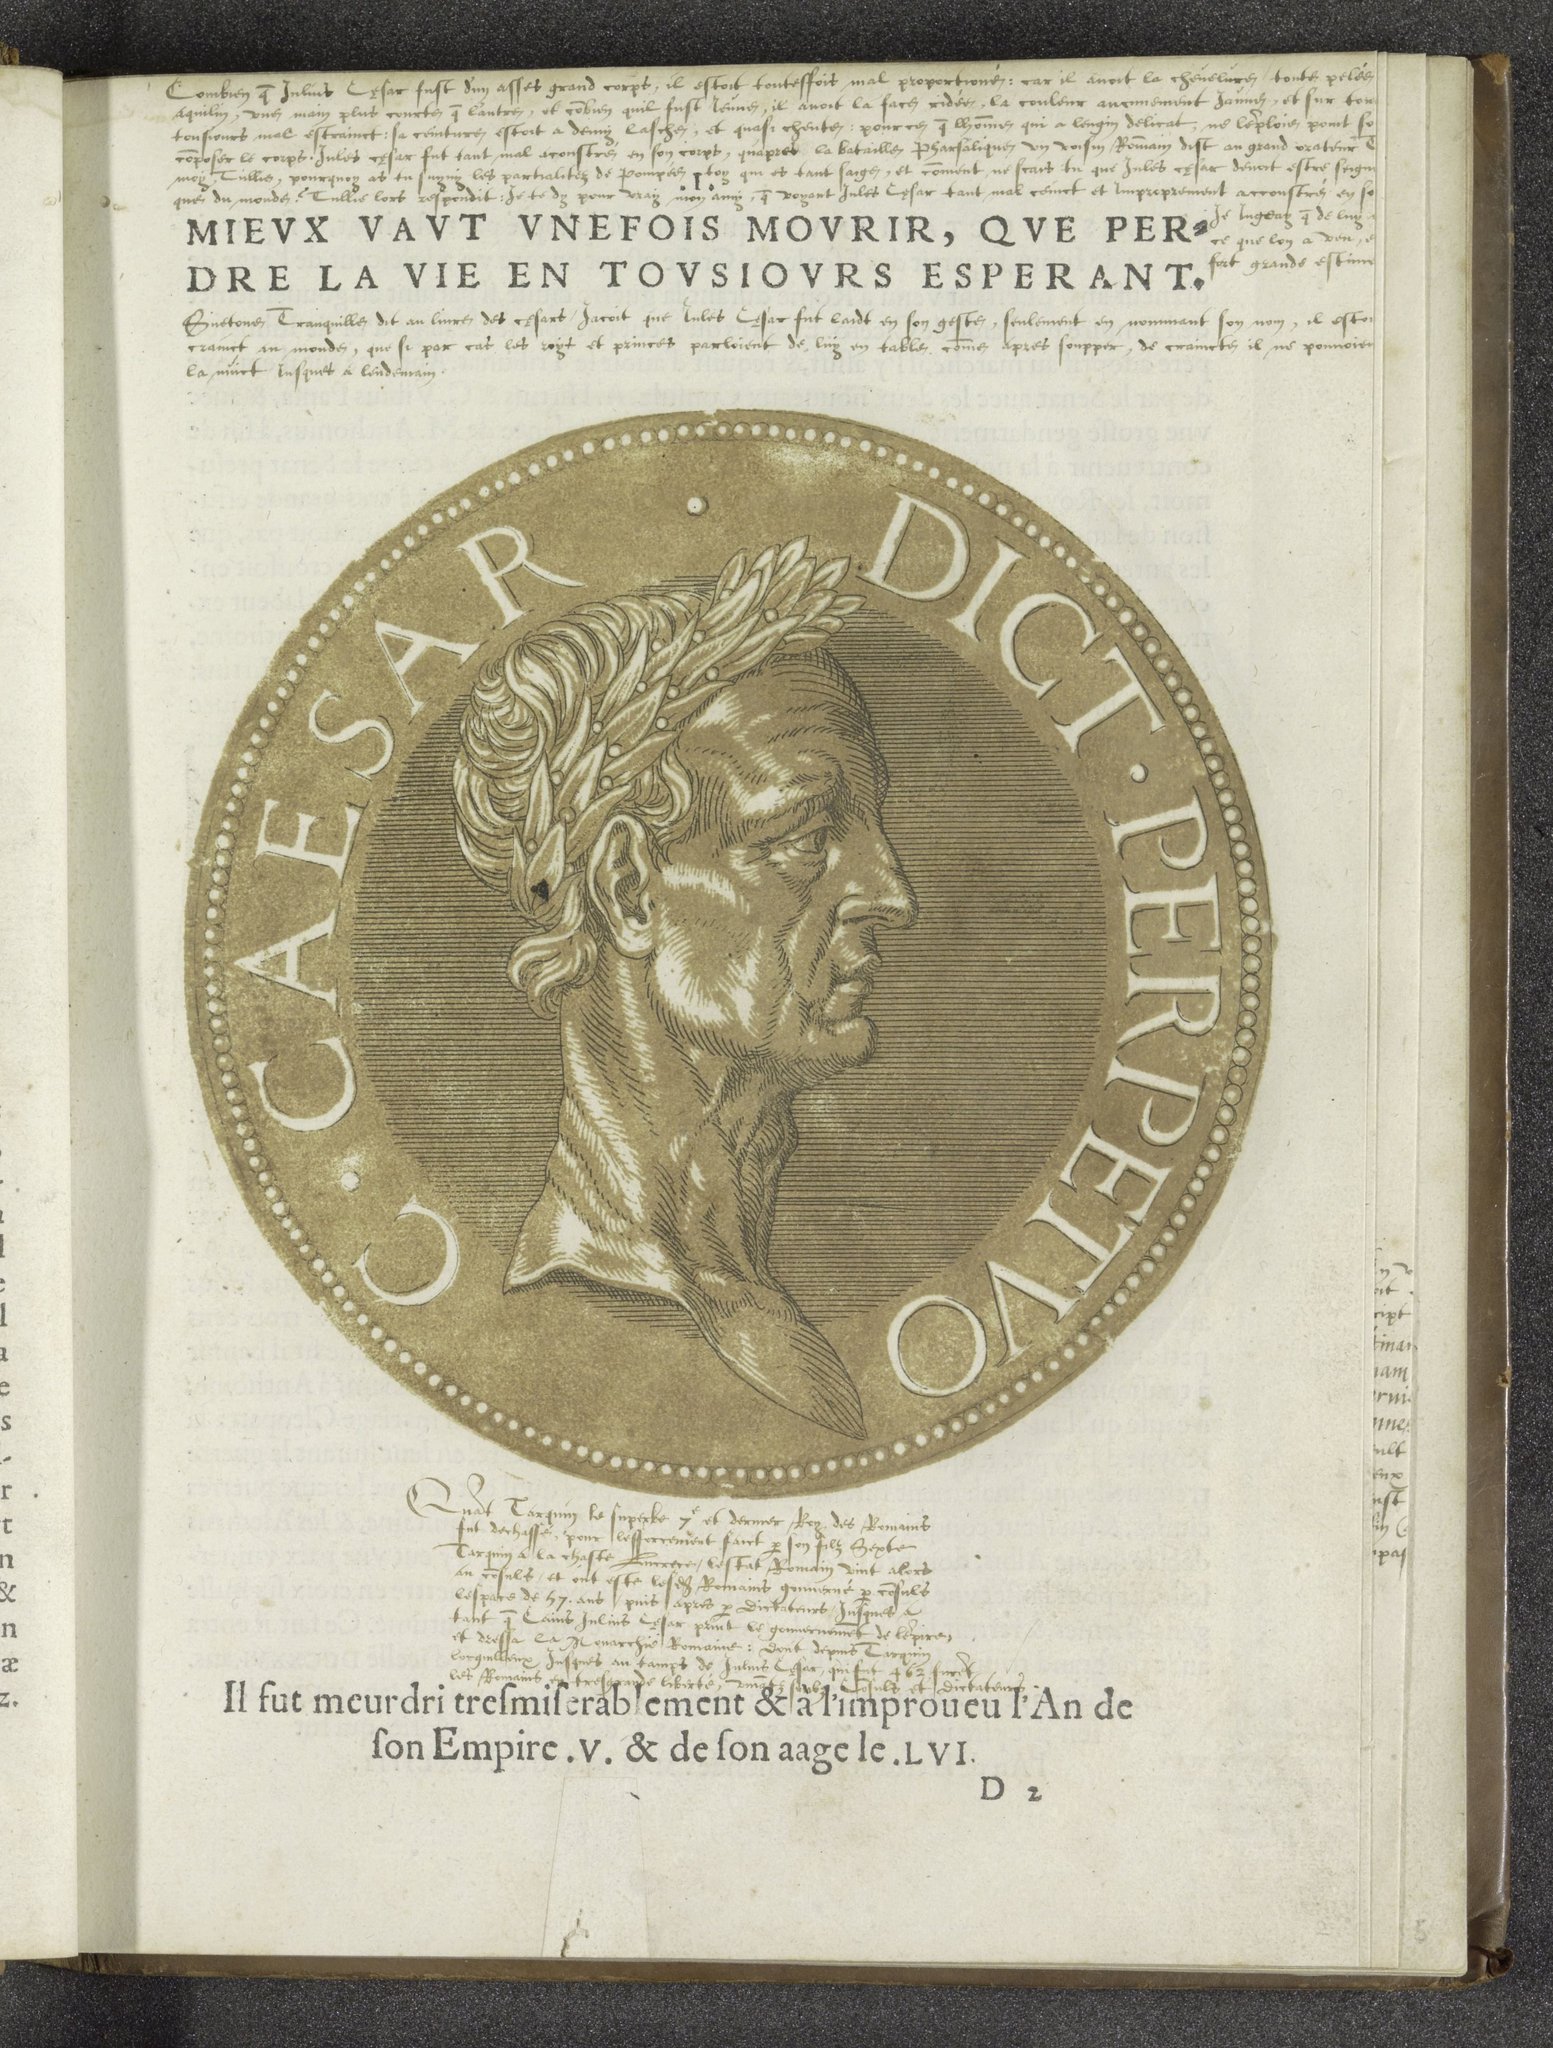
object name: print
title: Portret van Julius Caesar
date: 1557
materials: paper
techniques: woodcut, etching, letterpress printing, writing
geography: antwerp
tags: emperor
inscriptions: inscription: ‘Combien ...’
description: Portret van Julius Caesar op een munt, met randschrift. De prent maakt deel uit van een boek over de keizers vanaf Julius Caesar tot en met Karel V en zijn broer Ferdinand.